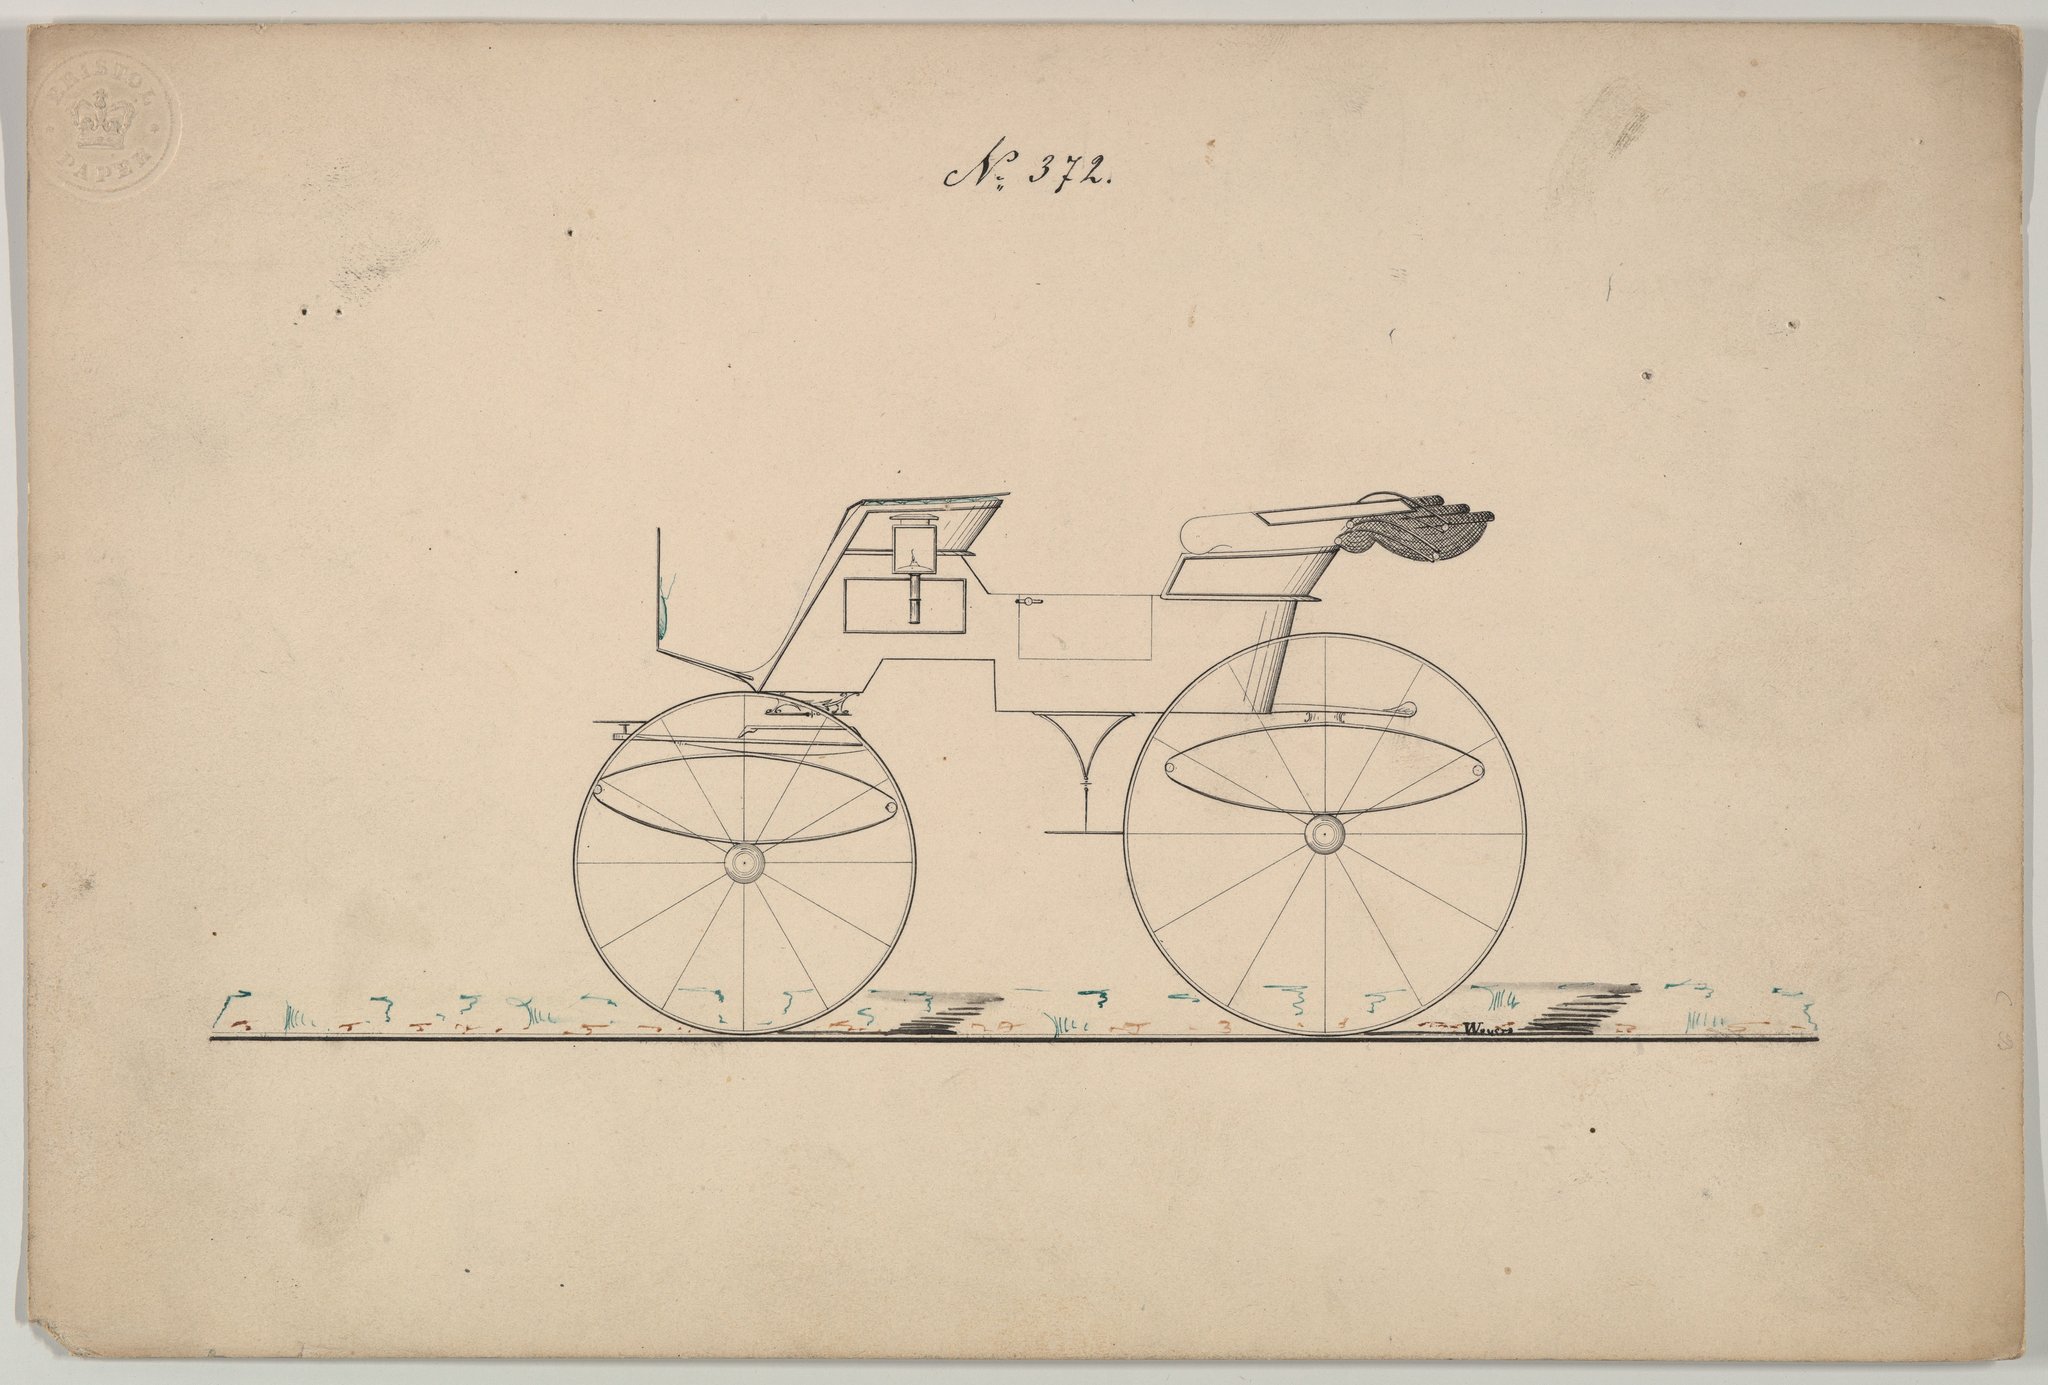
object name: drawing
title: Design for Phaeton, no. 372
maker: brewster & co.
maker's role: manufacturer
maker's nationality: american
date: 1850-1874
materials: gouache, ink, watercolor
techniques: pen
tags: carriages